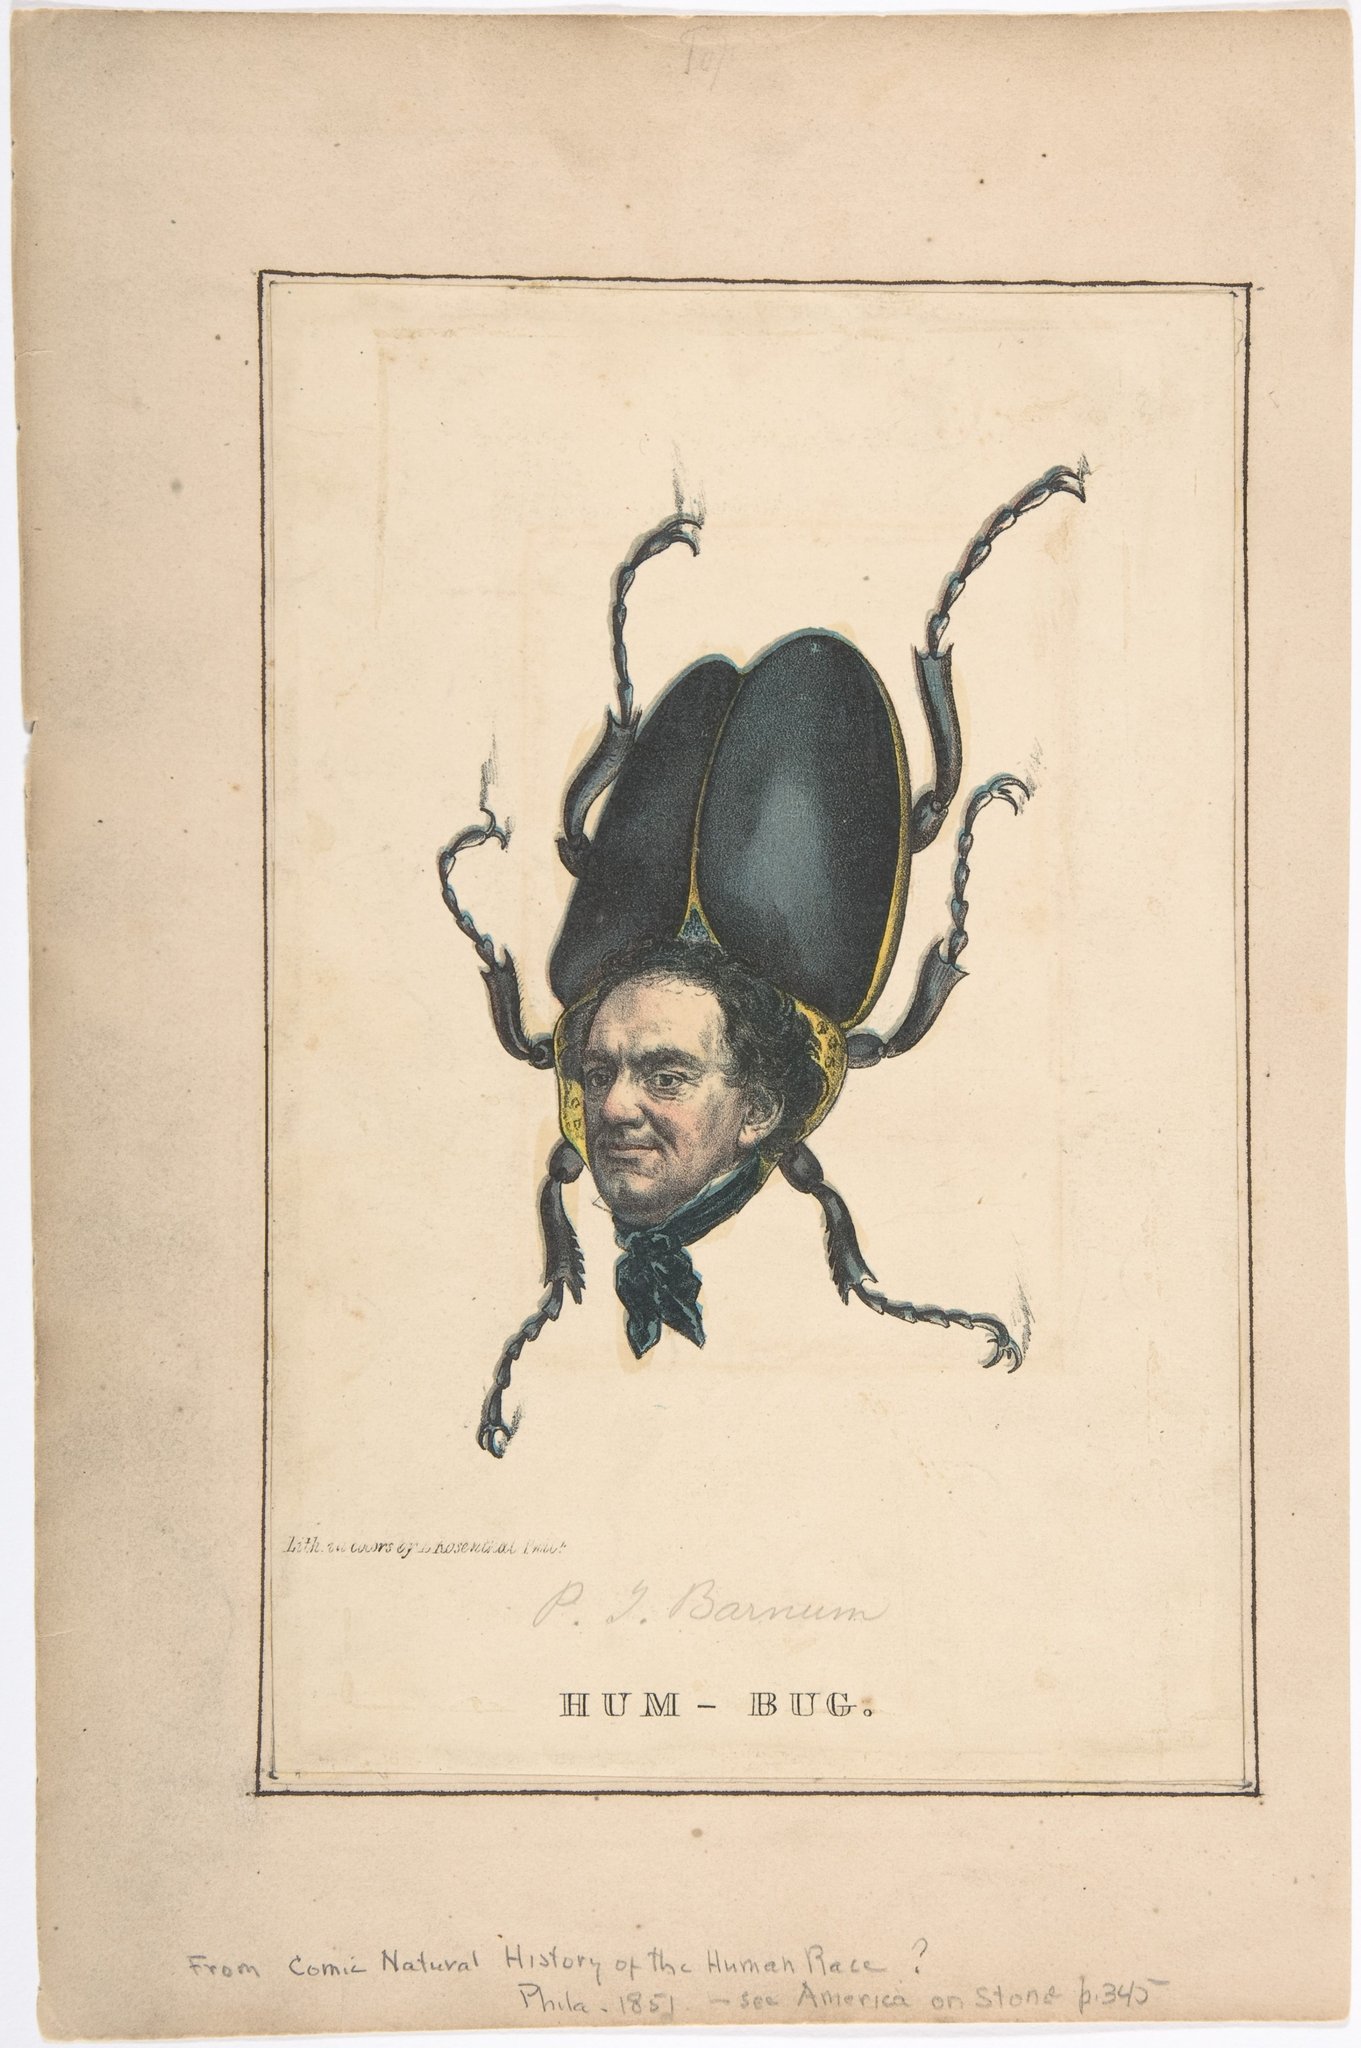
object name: print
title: Hum-Bug (P. T. Barnum), from "The Comic Natural History of the Human Race"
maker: henry louis stephens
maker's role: artist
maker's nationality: american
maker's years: 1824-1882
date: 1851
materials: watercolor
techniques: lithograph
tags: satire,heads,men,insects,caricature